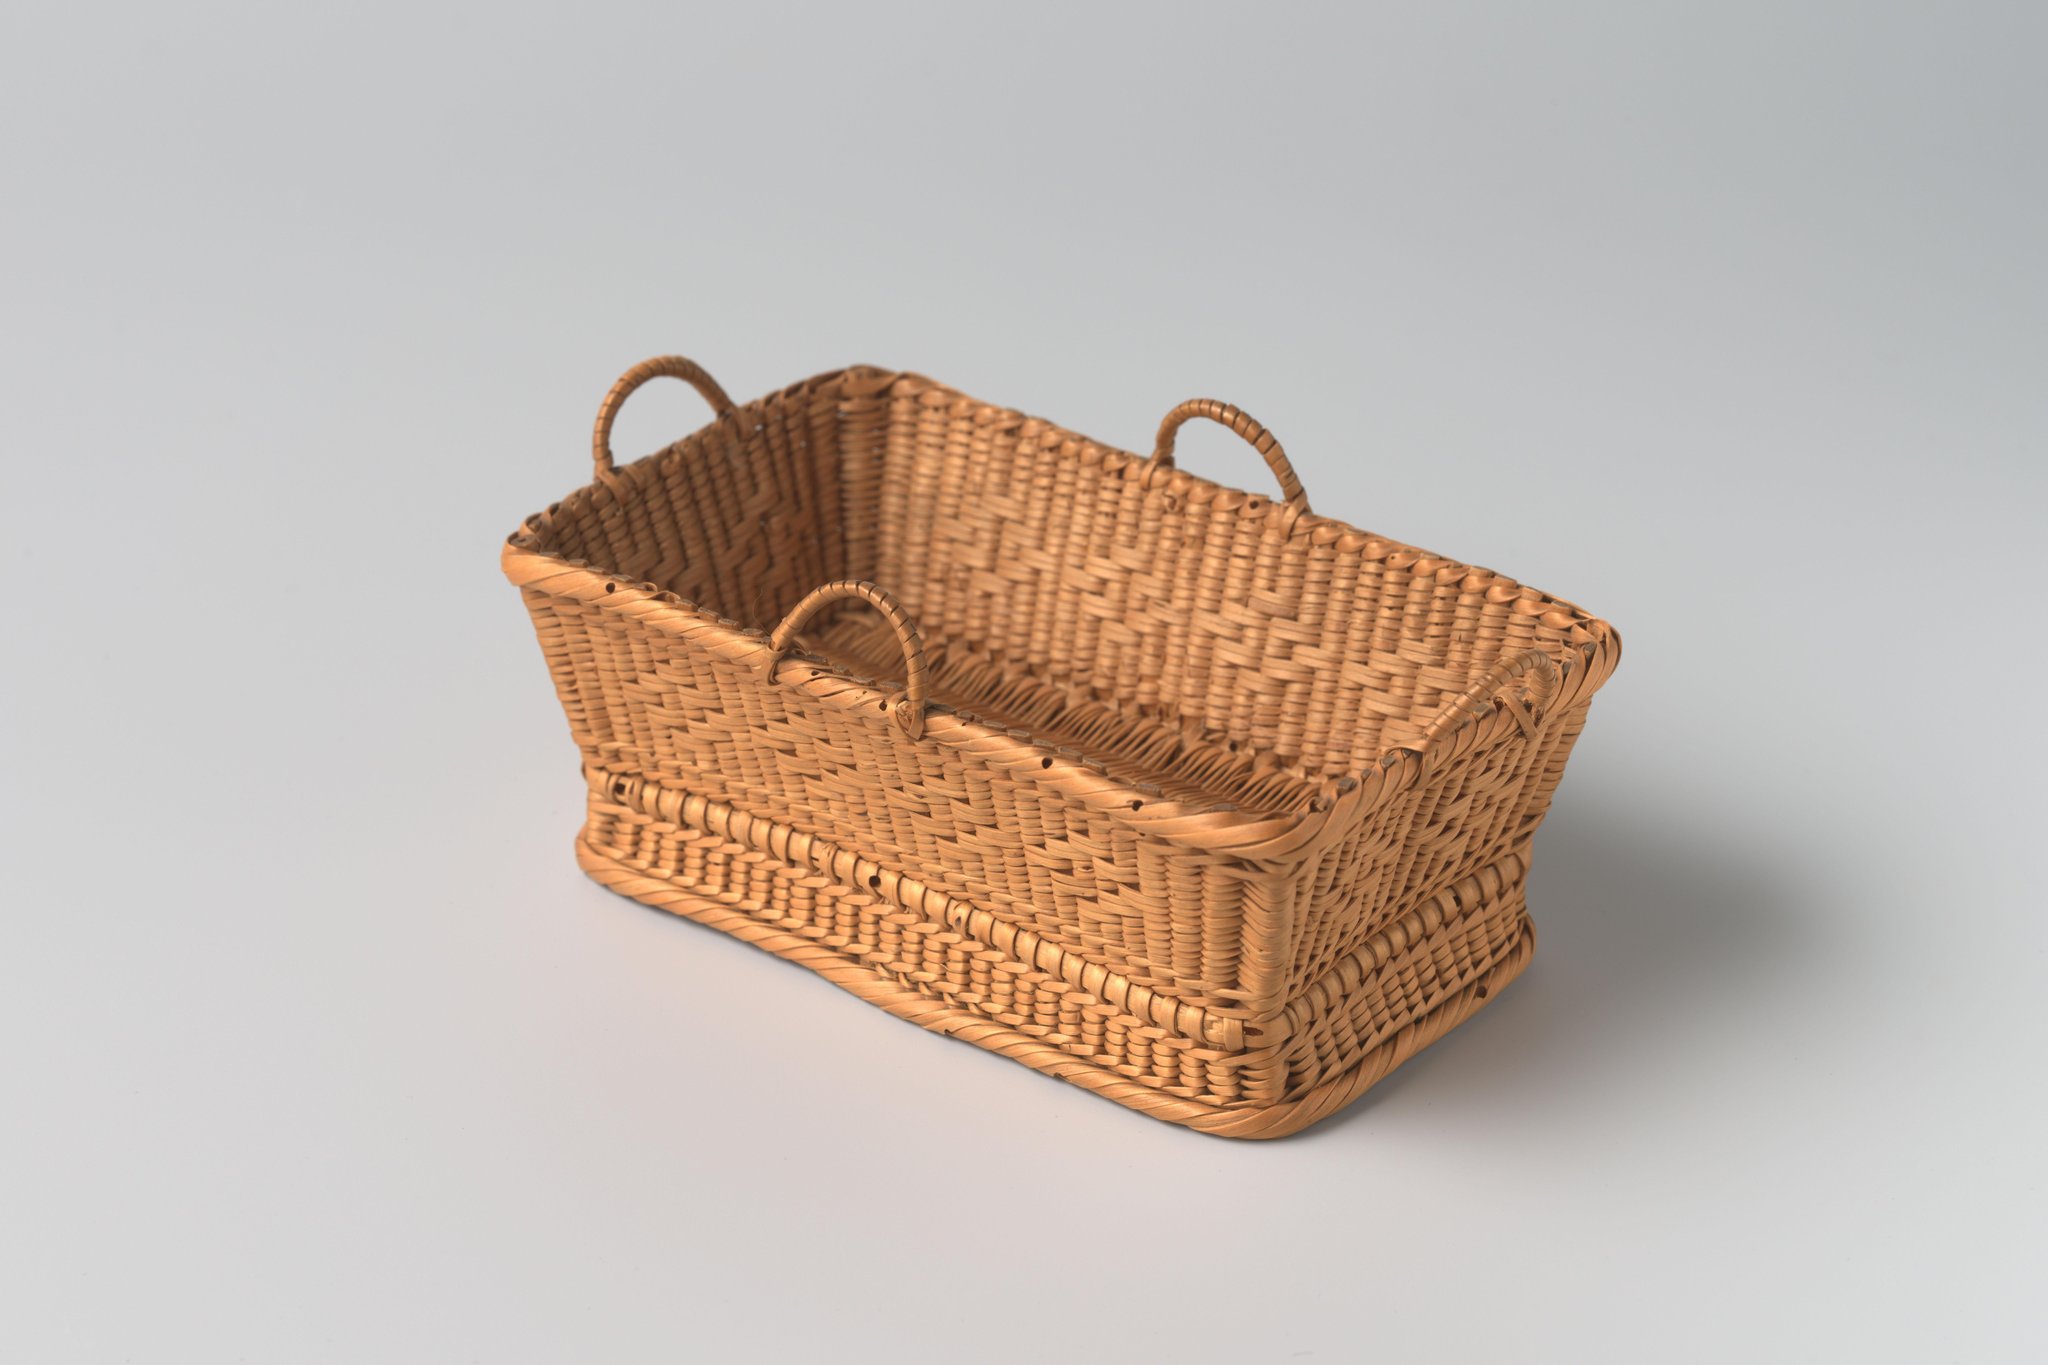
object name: baliemand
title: Baliemand vervaardigd van gespleten wilgenteen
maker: Anonymous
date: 1676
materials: plant material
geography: halle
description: Baliemand, rechthoekig van vorm, van gespleten wilgenteen, fijnscheenwerk, met ingevlochten ruitmotieven en vier handvatten.